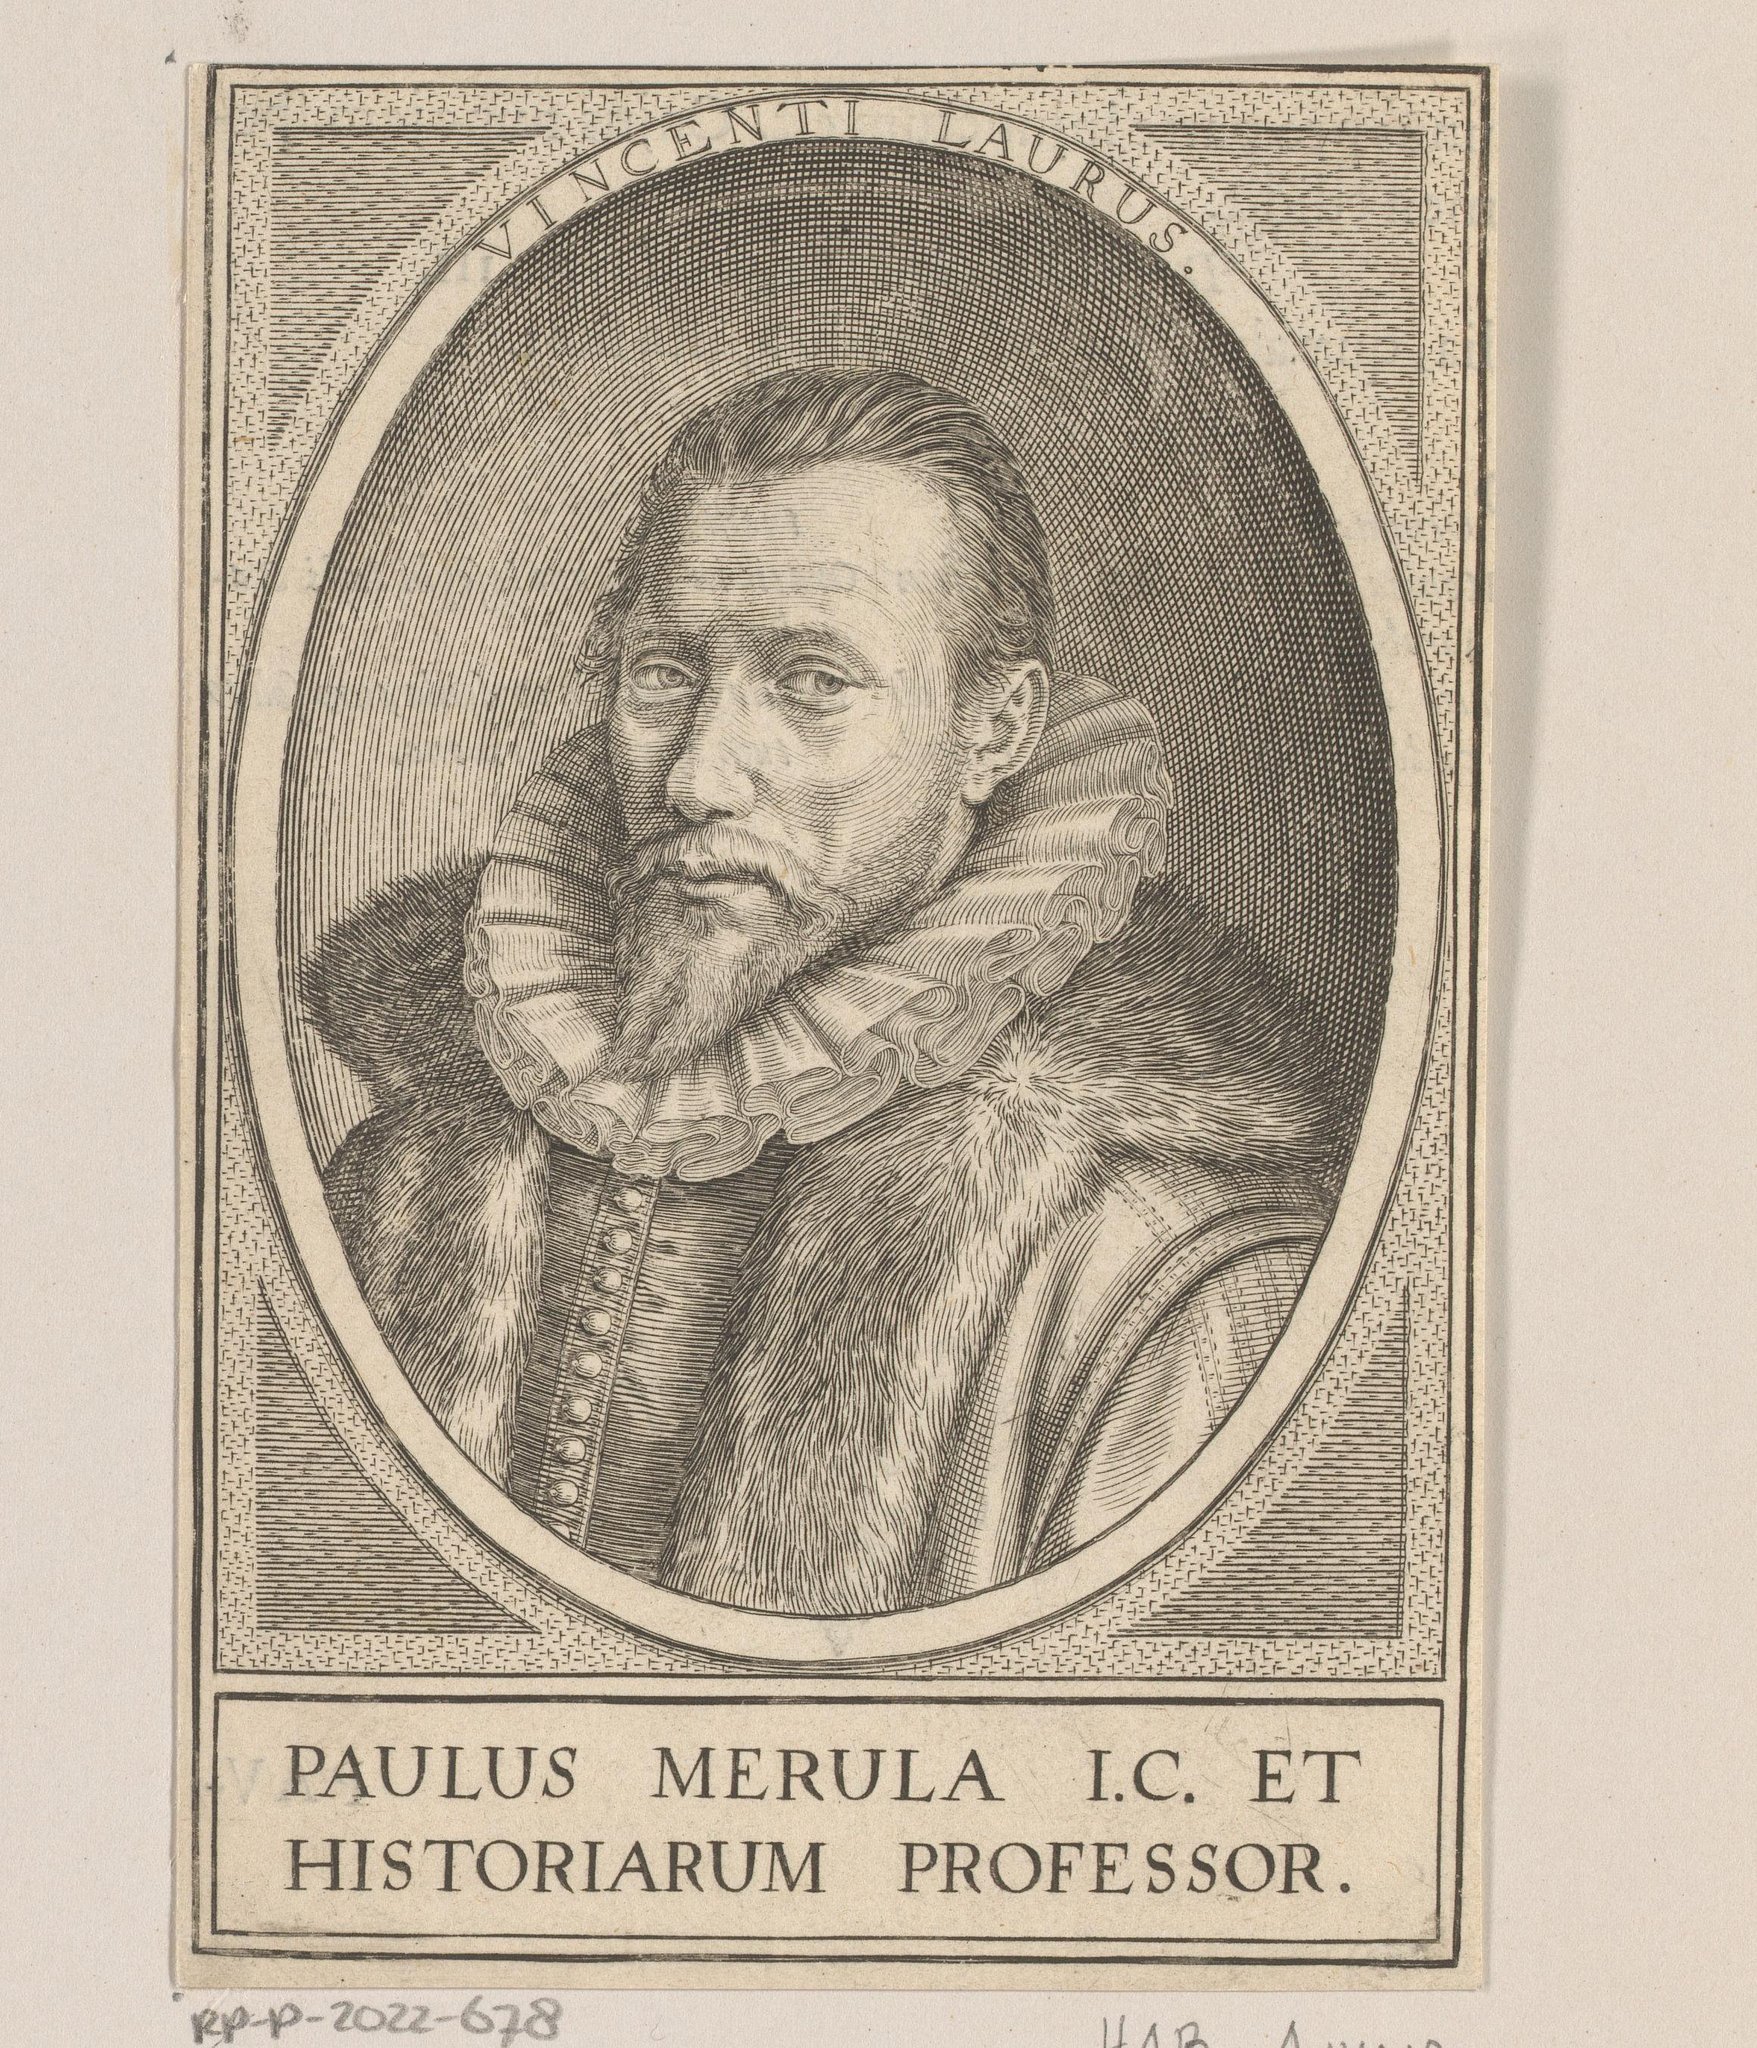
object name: book illustration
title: Portret van Paulus Merula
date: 1613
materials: paper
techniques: engraving, letterpress printing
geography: leiden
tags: paulus merula, moustache, historical persons, beard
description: Prent uit: Muers, Johannes van. Illustris academia Lugd-Batava, id est: Virorum clarissimorum icones, elogia ac vitae, qui eam scriptis suis illustrarunt (...). Leiden: Andries Clouck, 1613.